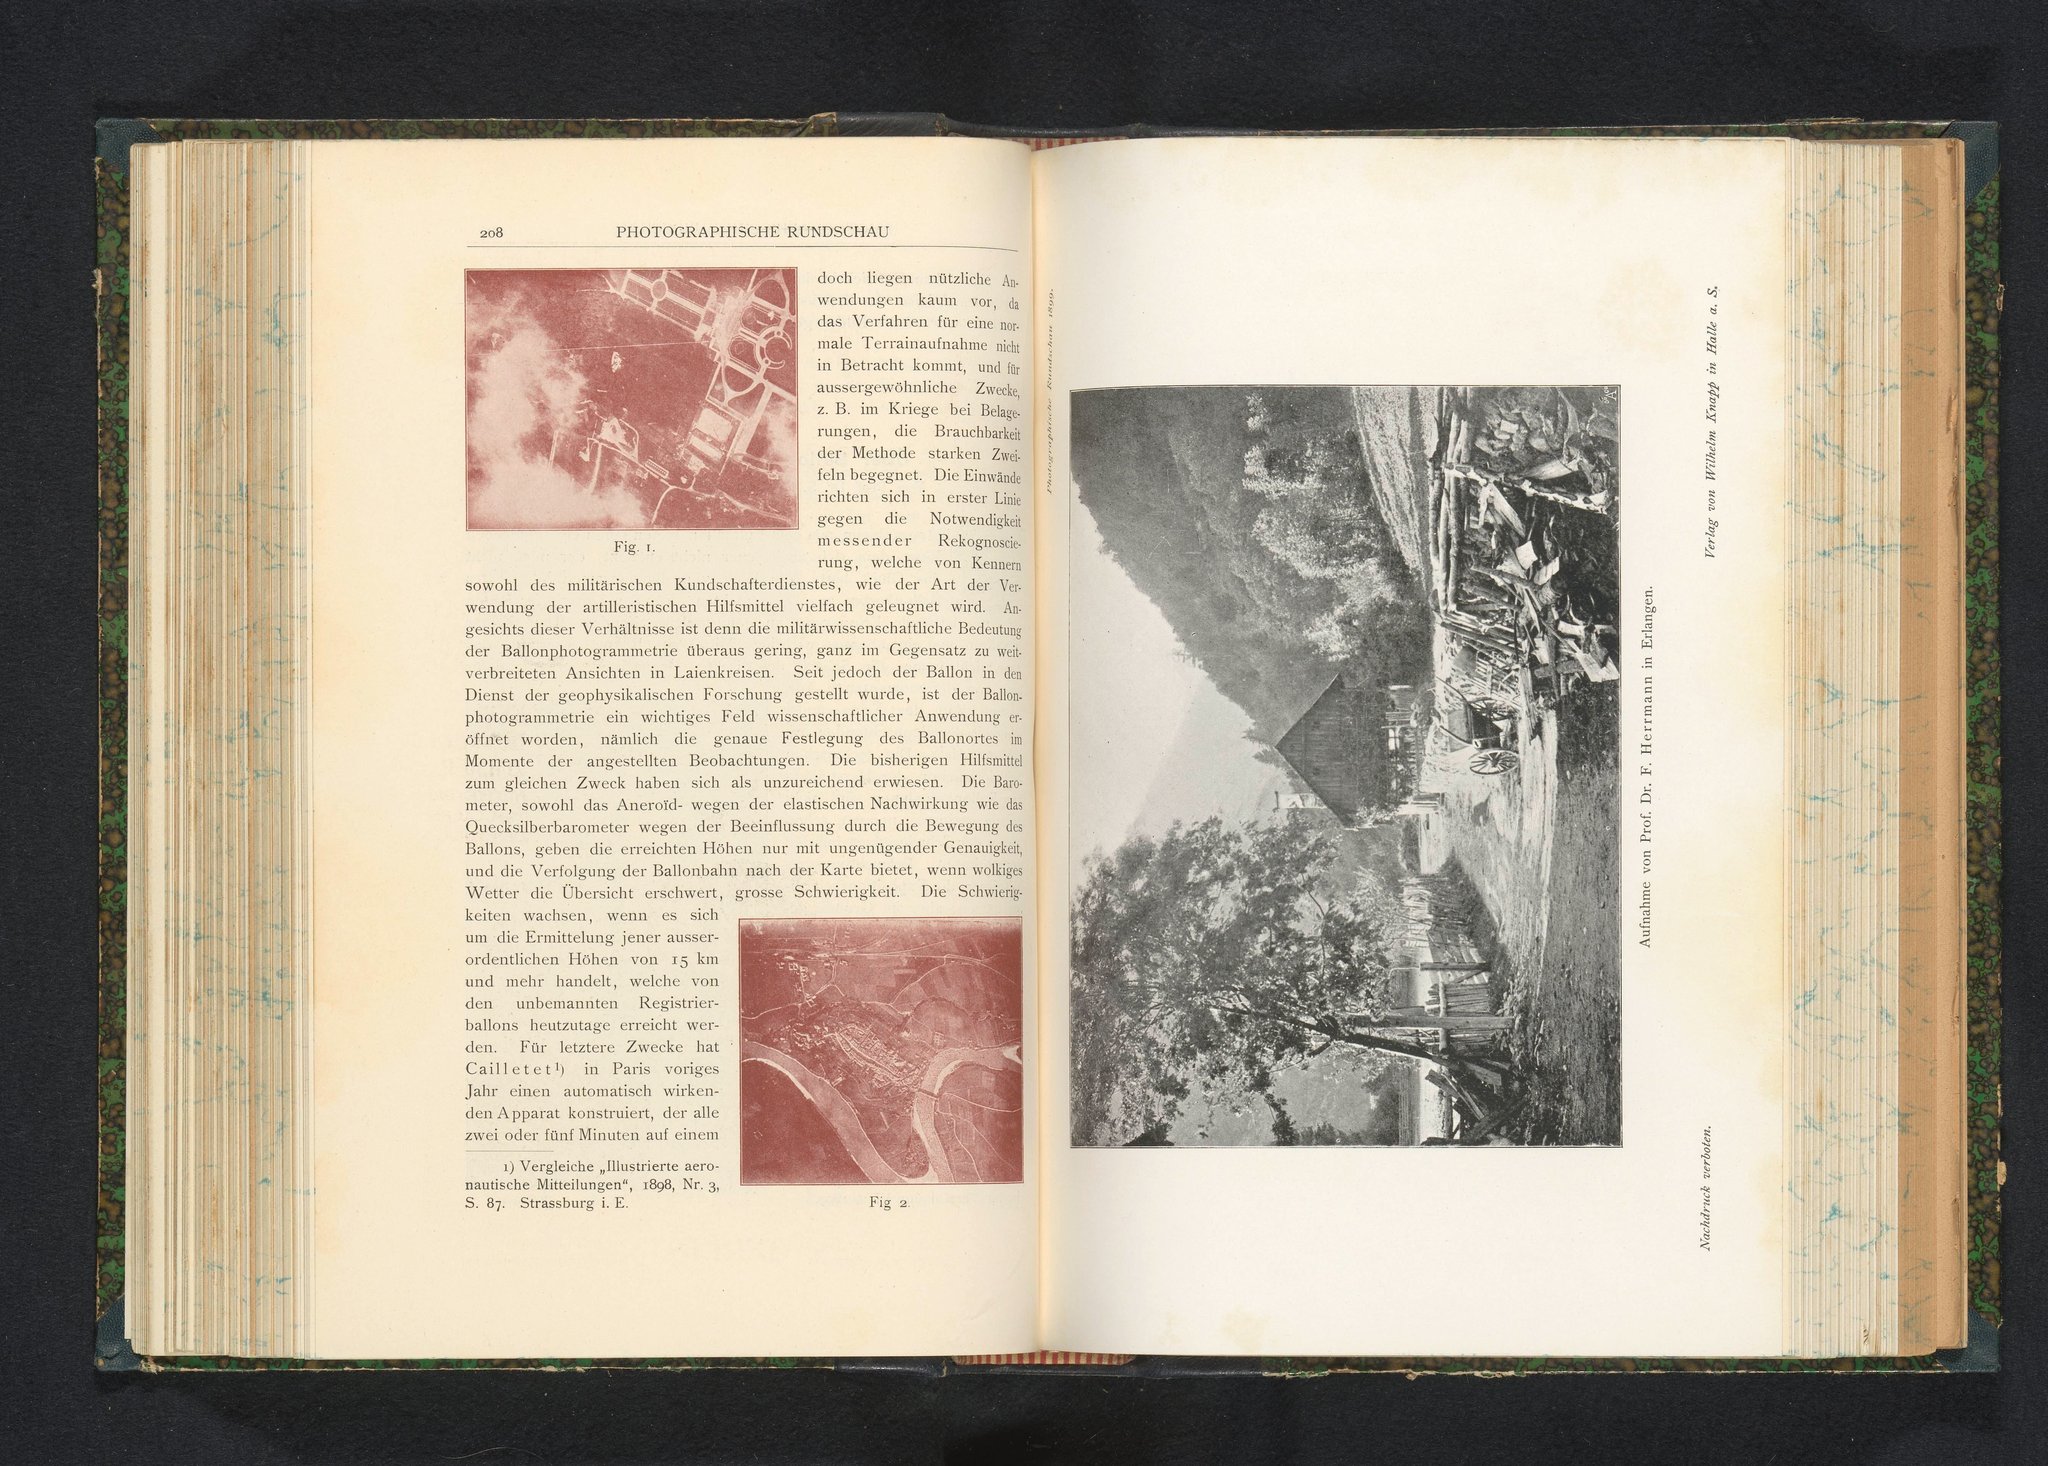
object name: page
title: Gezicht op een landweg en op de achtergrond een huis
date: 1894-1899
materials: paper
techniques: autotype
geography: halle an der saale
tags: rural housing, e.g. country-house, villa, cottage, road, path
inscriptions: monogram: ‘Dr A Co’